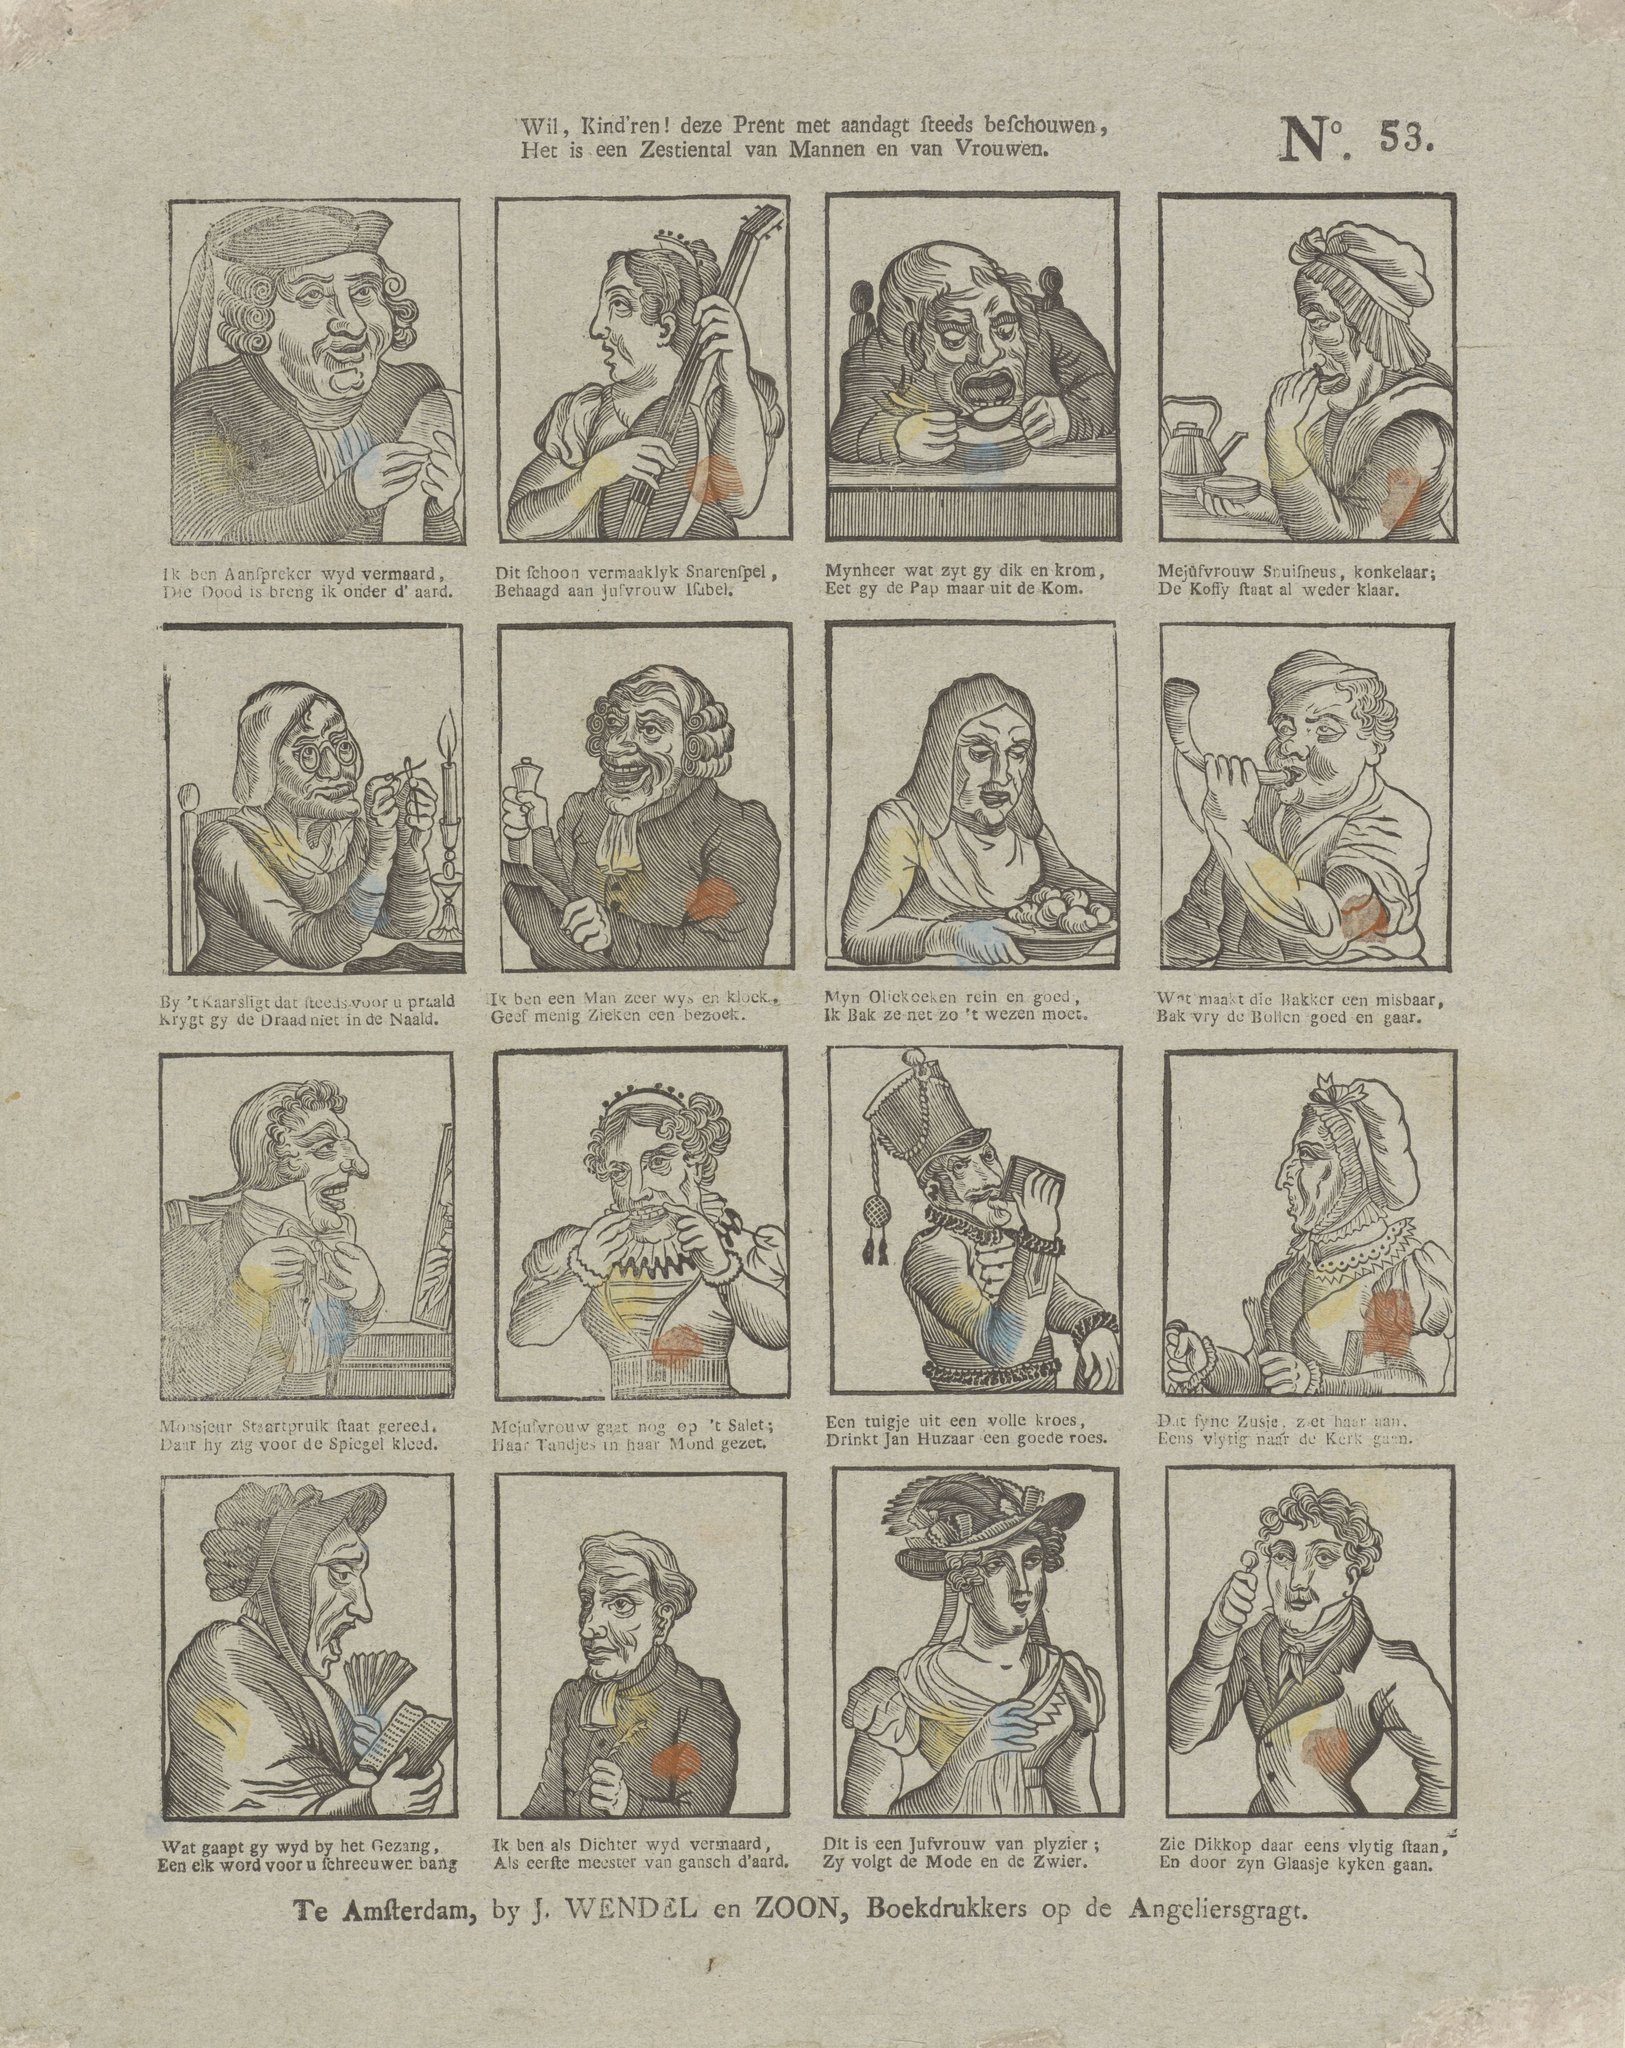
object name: print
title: Wil, kind'ren! deze prent met aandagt steeds beschouwen, / Het is een zestiental van mannen en van vrouwen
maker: Anonymous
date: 1819-1842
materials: paper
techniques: colour, letterpress printing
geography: amsterdam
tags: caricatures (human types), characters (human types)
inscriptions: collector's mark: Lugt 2760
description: Blad met 16 voorstellingen van verschillende typen mannen en vrouwen. Onder elke afbeelding een tweeregelig vers. Genummerd rechtsboven: No. 53.